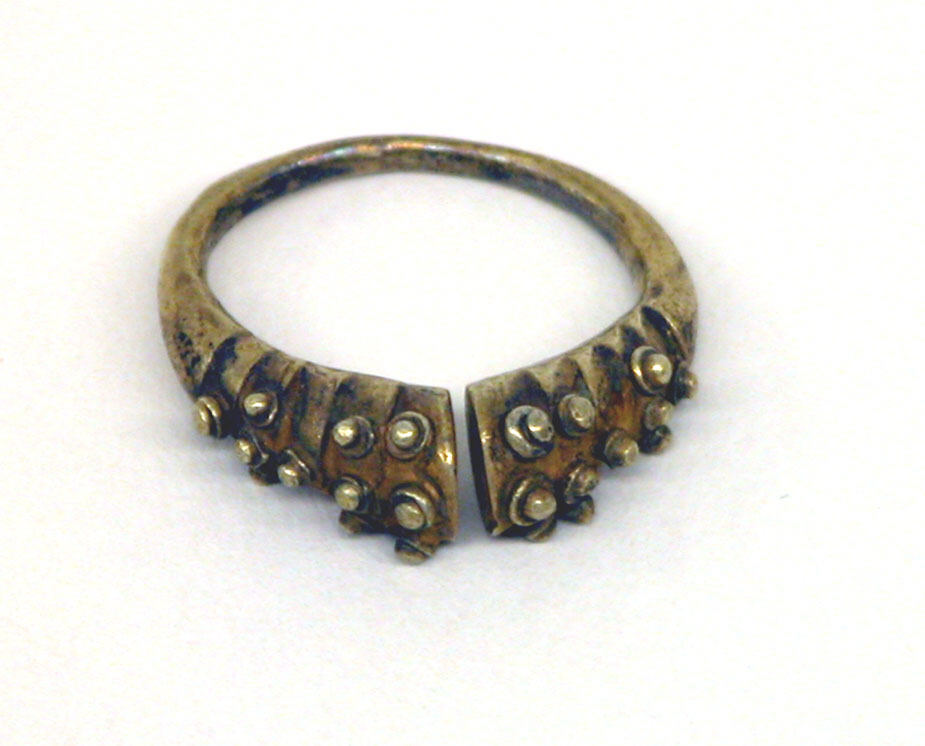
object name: ear clip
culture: indonesian, javanese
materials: gold